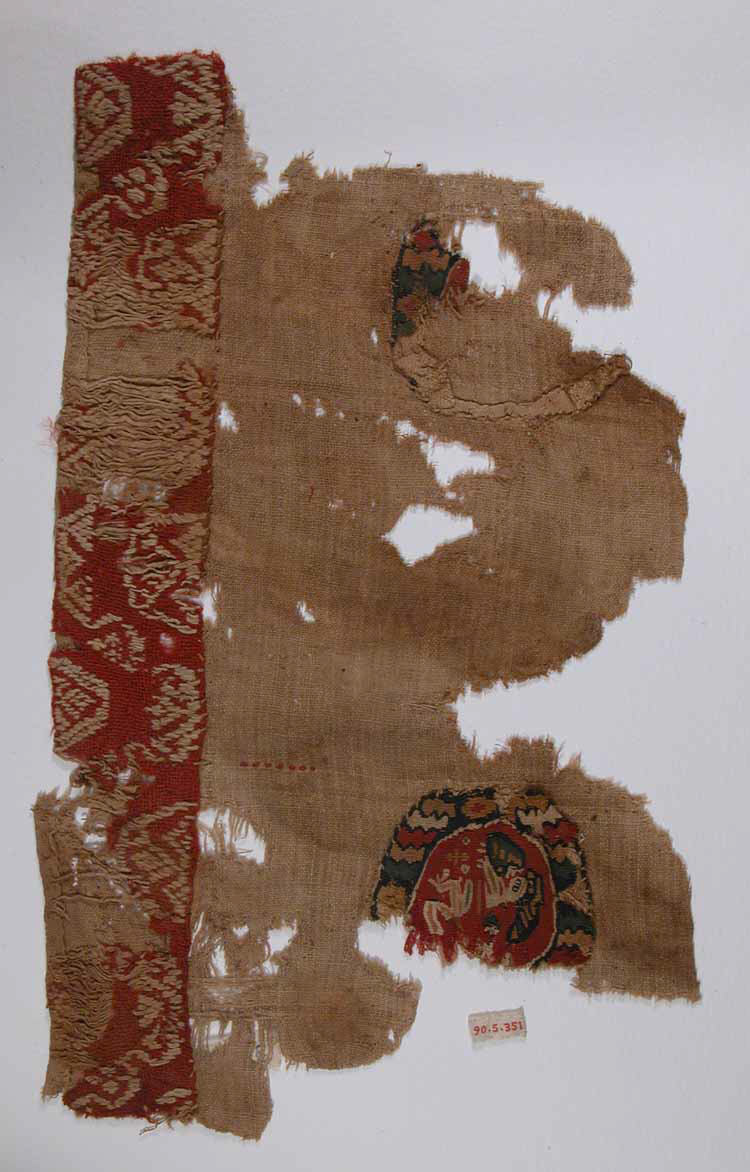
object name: textile fragment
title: Fragment of a Tunic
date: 401-600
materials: linen, wool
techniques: weave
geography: egypt